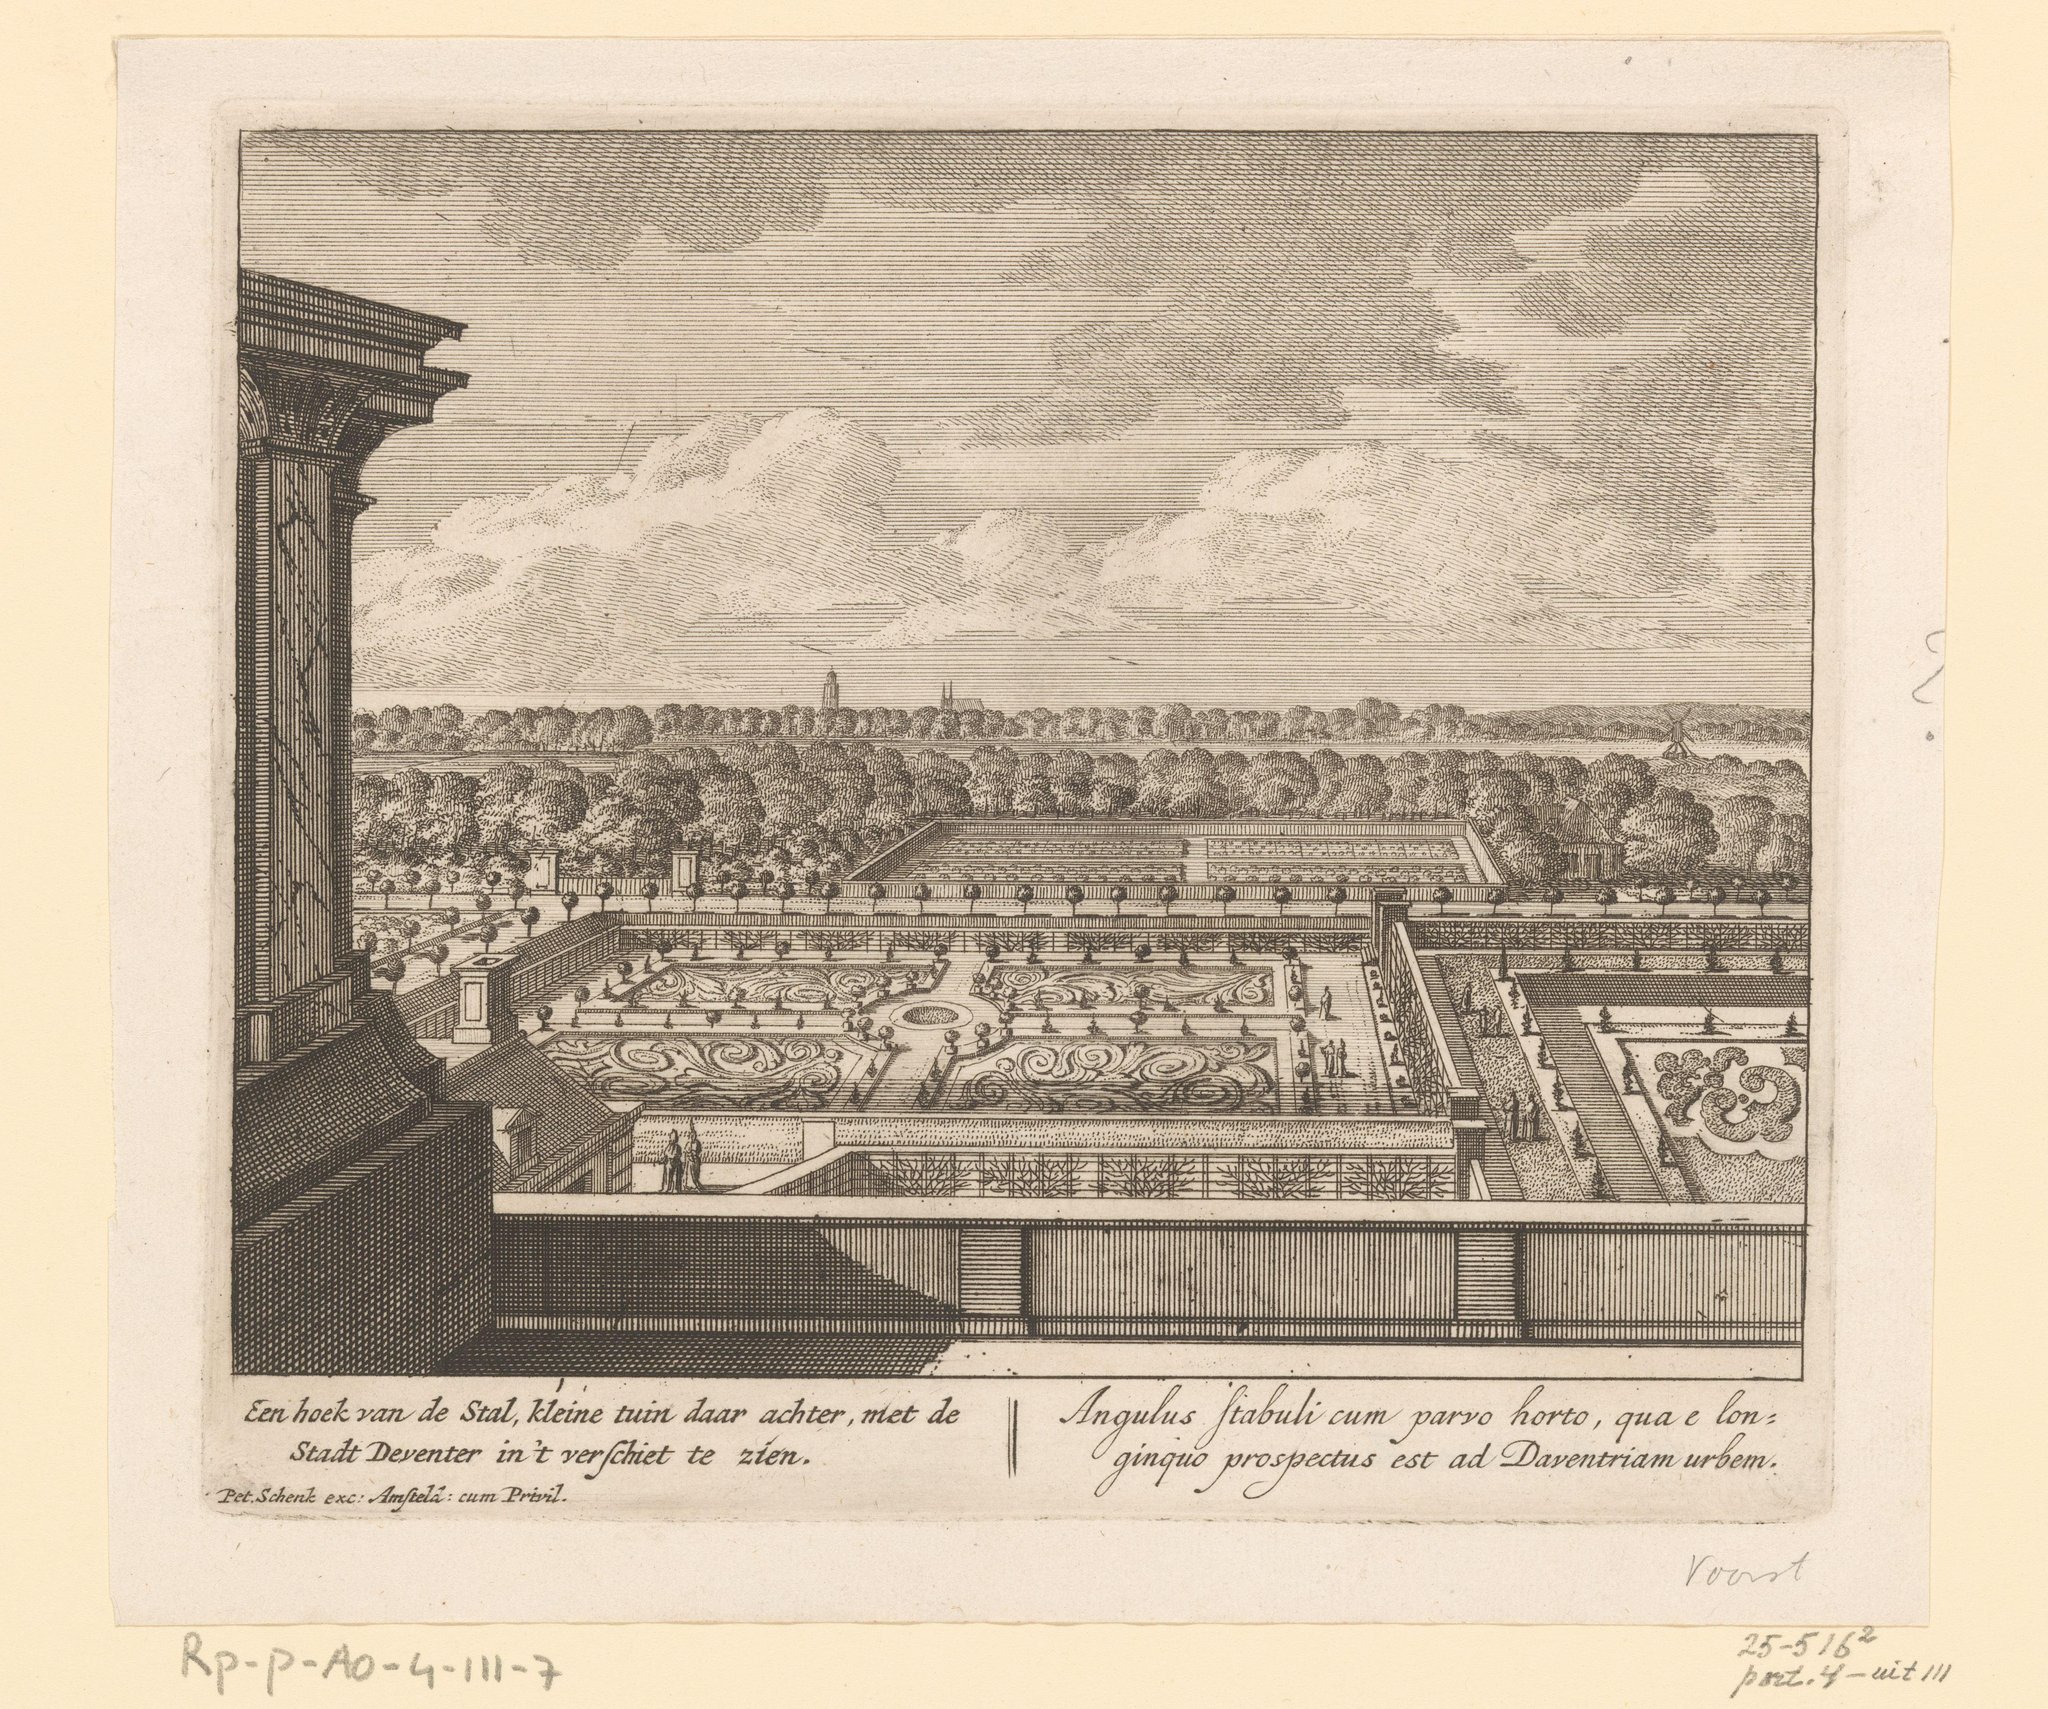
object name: print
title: Een hoek van de stal, kleien tuin daar achter, met de stadt Deventer in 't verschiet te zien / Angulus stabuli cum parvo horto, qua e longinquo prospectus est ad Daventriam urbem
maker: pieter schenk (i)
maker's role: print maker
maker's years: 1660-1711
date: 1700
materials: paper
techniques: engraving, etching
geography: amsterdam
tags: palace, french or architectonic garden; formal garden, deventer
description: Prent is uitgeven door Pieter Schenk (I) als onderdeel van de zestiendelige prentserie 'Praetorium Dieranum', ca. 1700. Later is de prent ook gebruikt in: Schenk, Pieter (I). Paradisus Oculorum: sive conspectus degantissimi centum (...). Jacobus Romanus, ca. 1700.